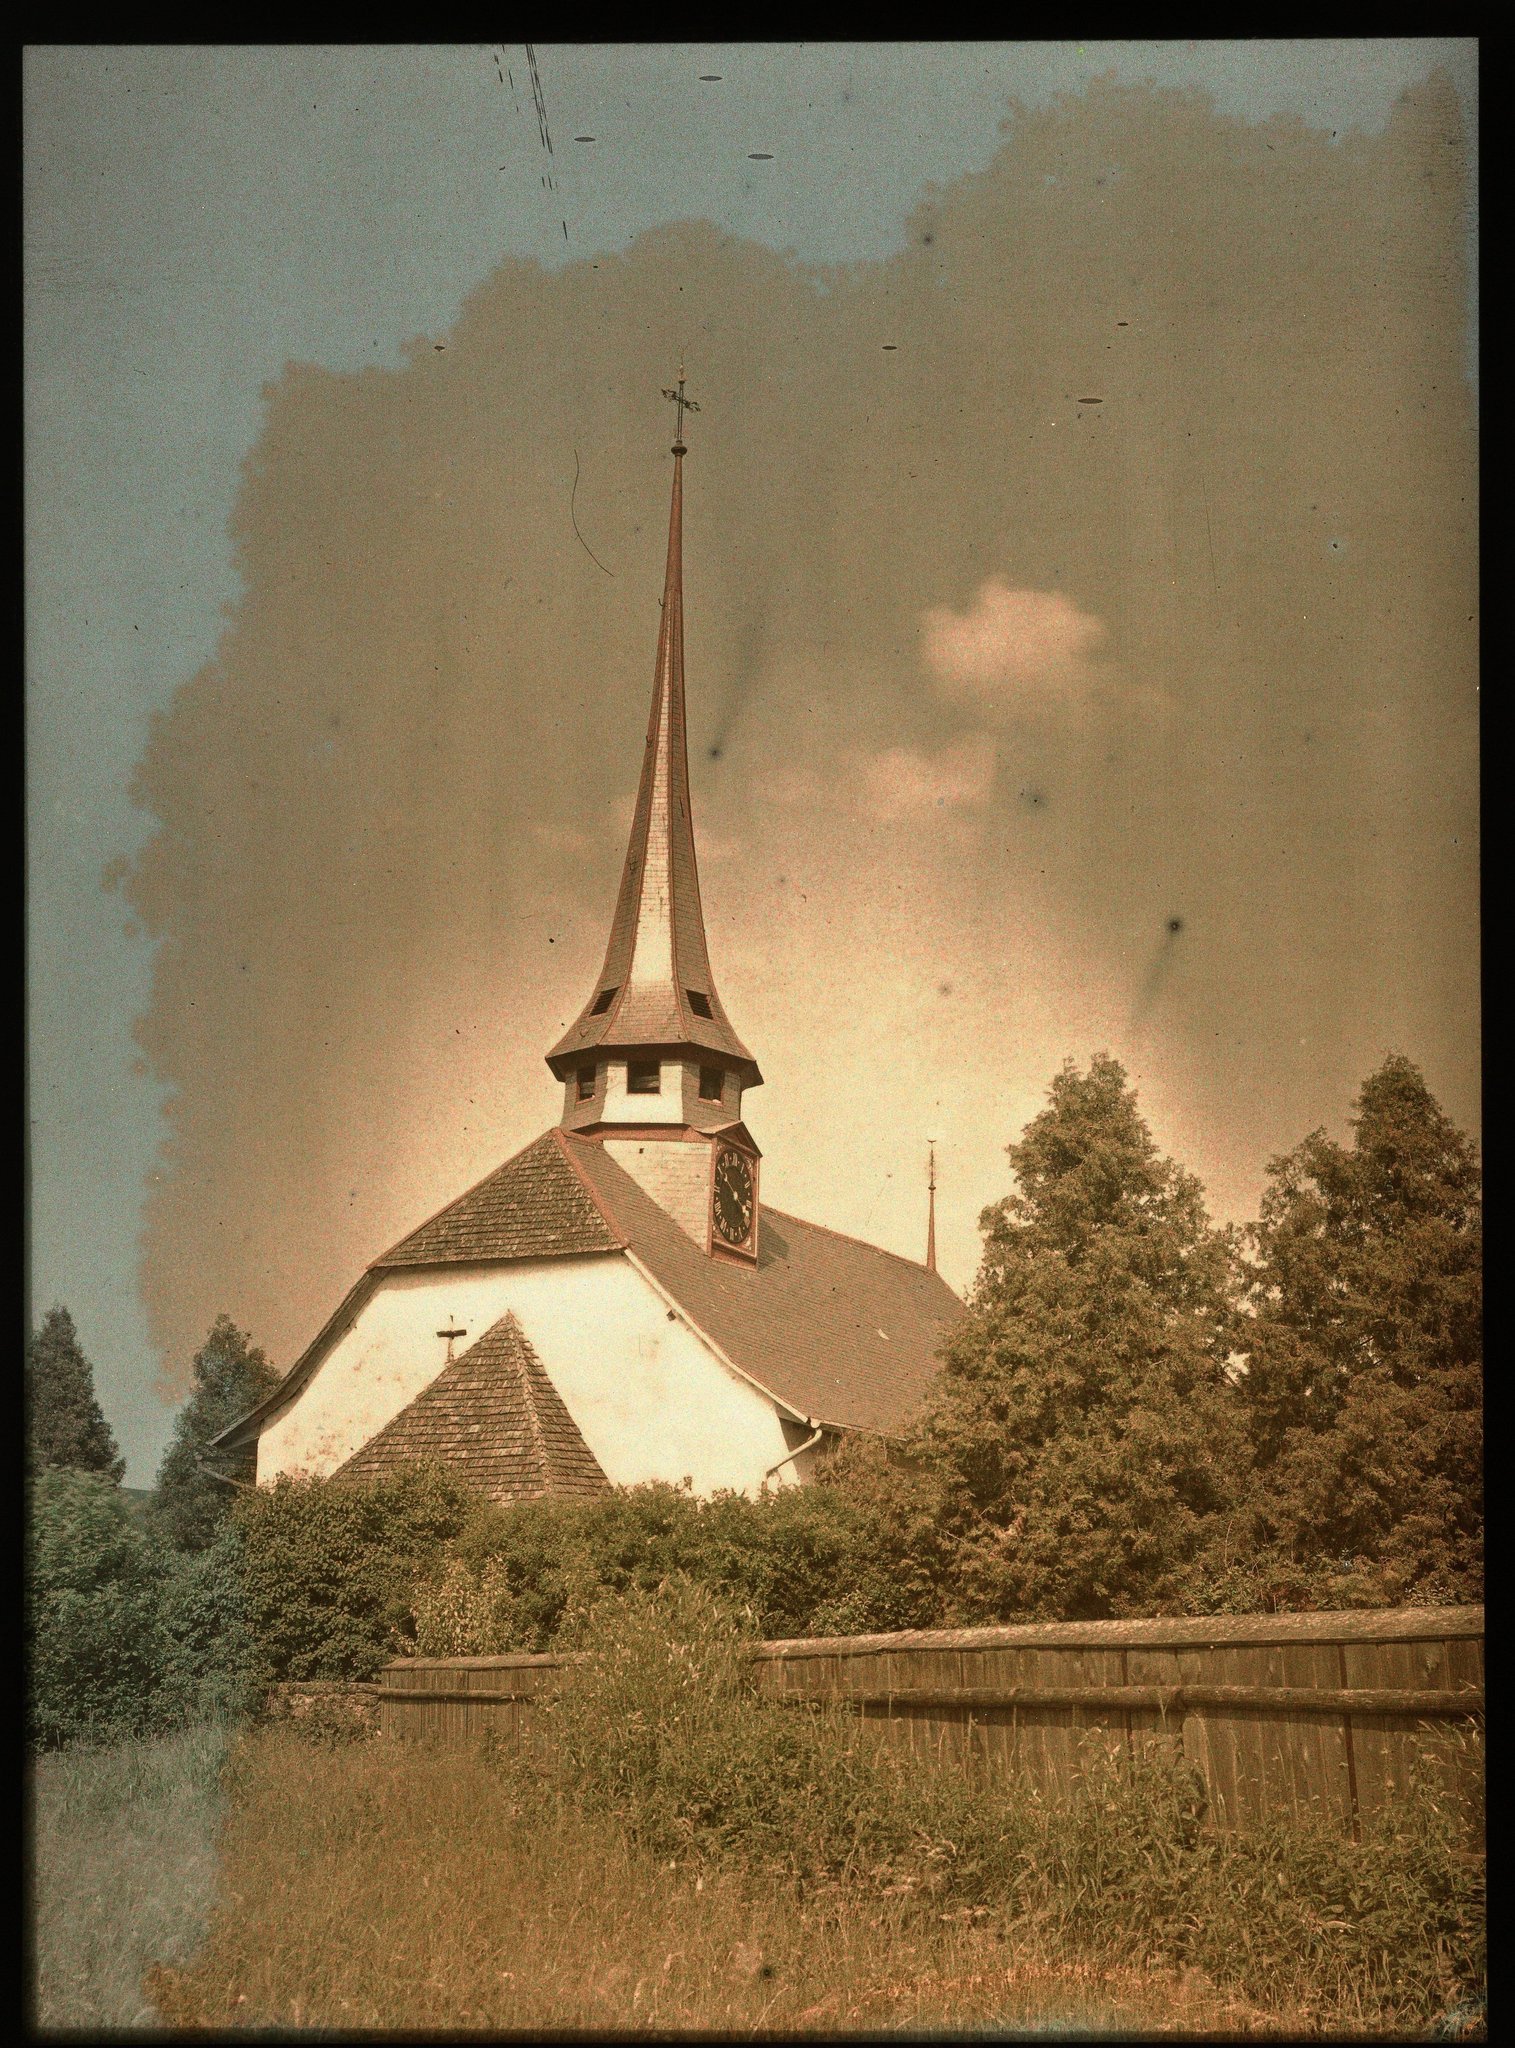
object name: glasdia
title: Gezicht op een kerk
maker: adolphe burdet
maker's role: fotograaf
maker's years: 1860-1940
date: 1907-1930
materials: glass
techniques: autochrome process, slide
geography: hasle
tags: switzerland